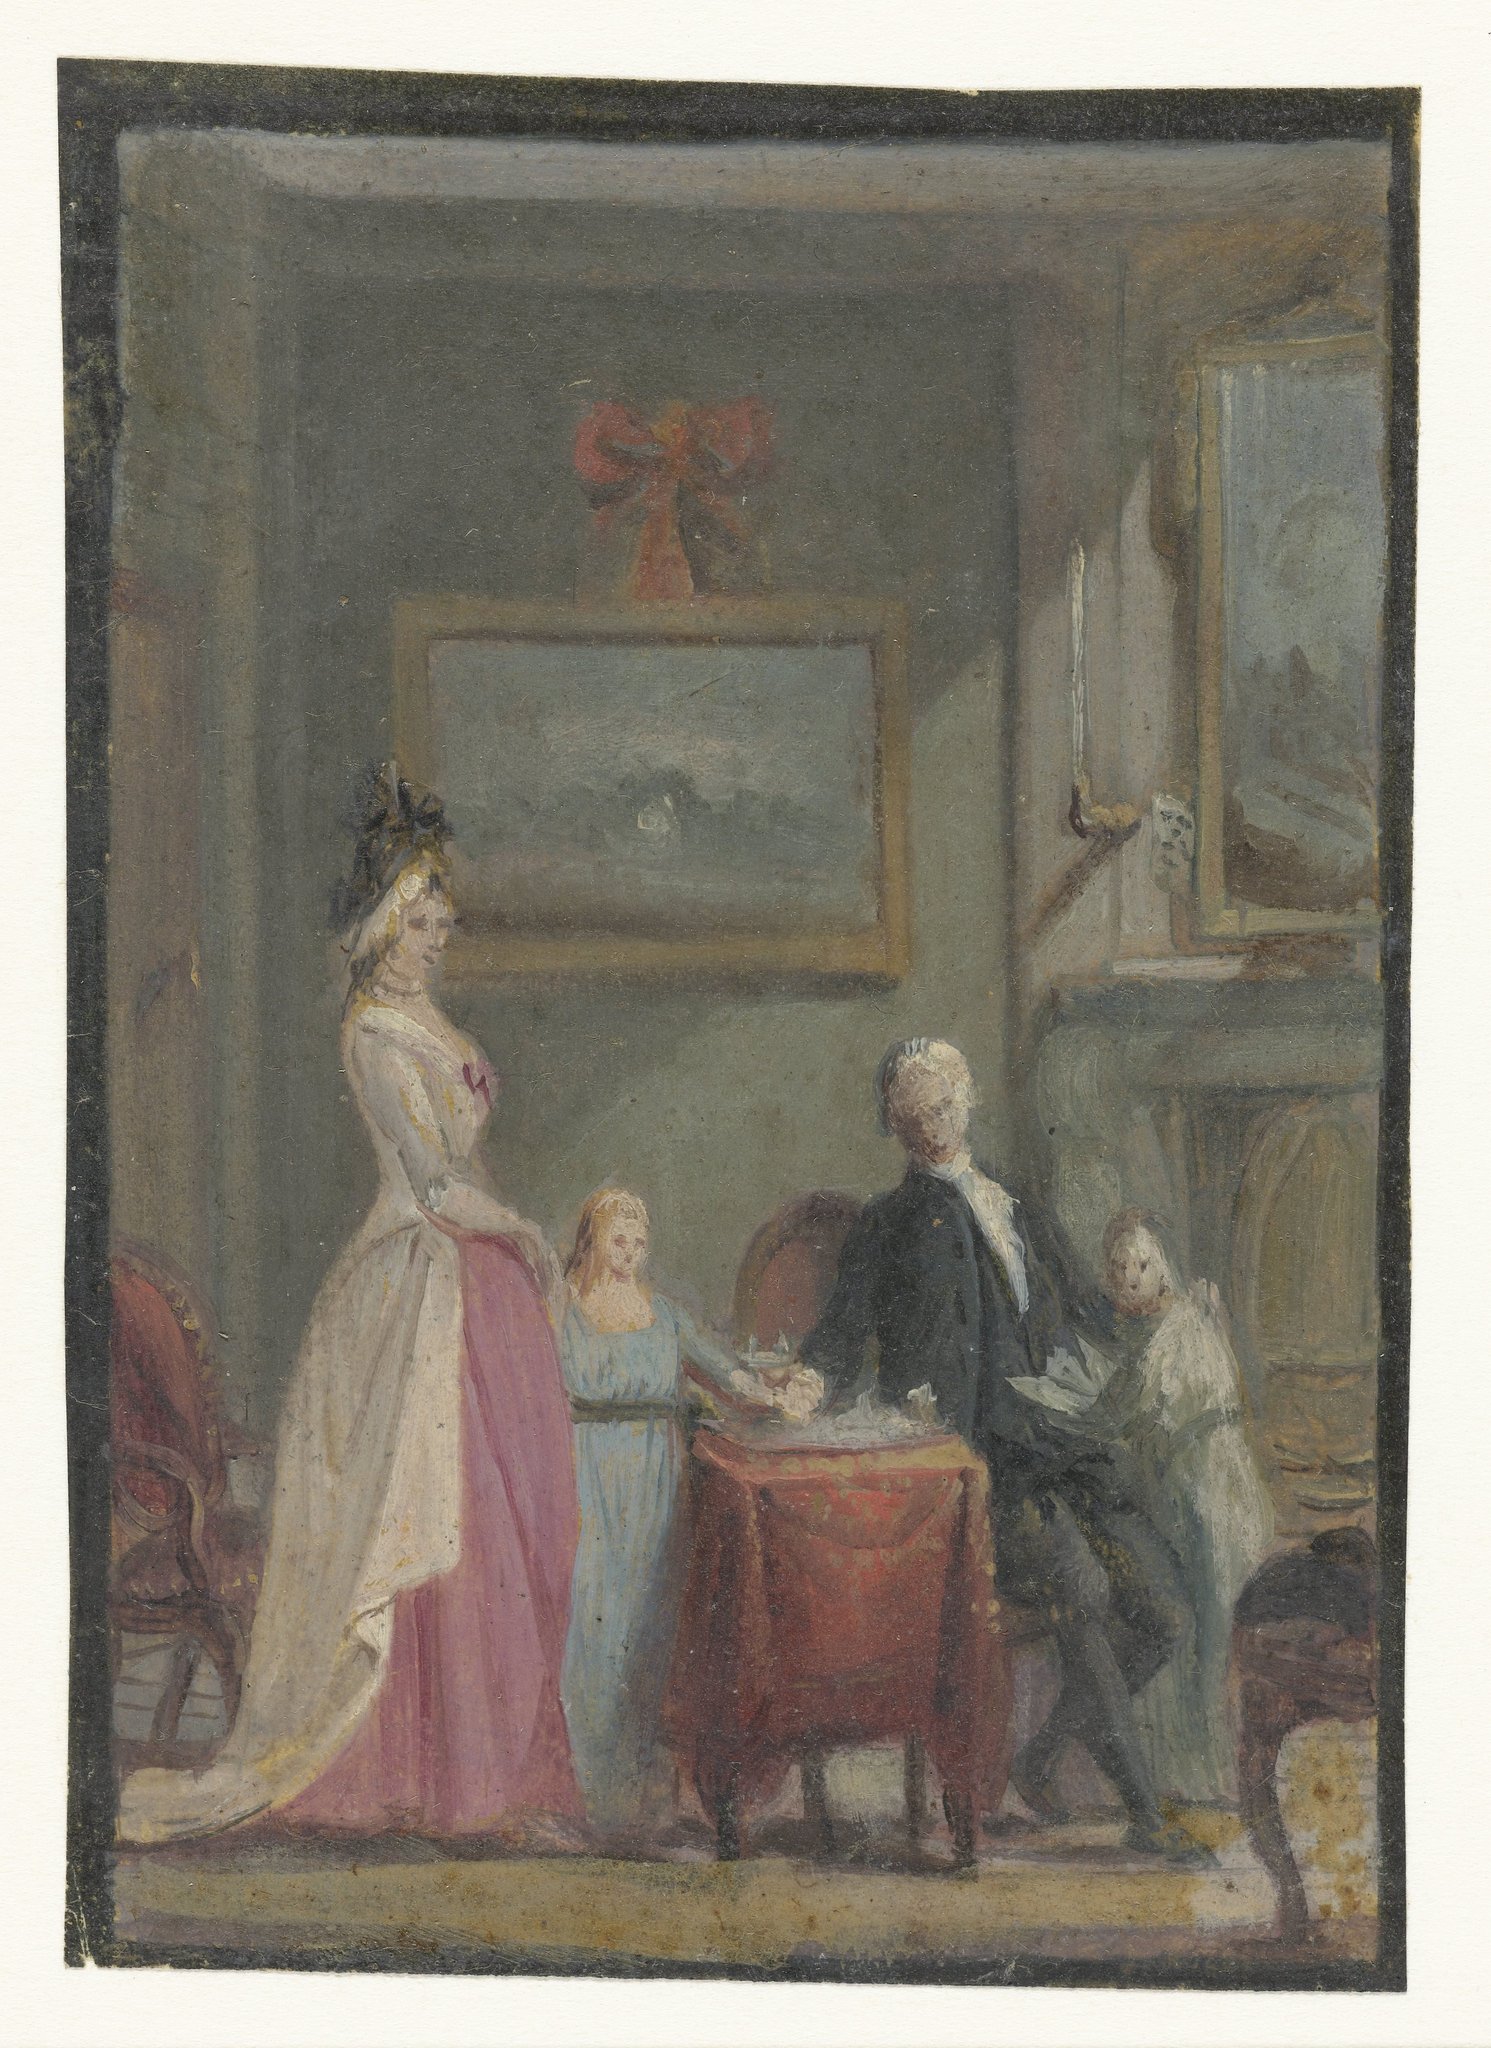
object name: drawing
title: Familiegroep in interieur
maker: Anonymous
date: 1700-1800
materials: oil, paper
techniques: brush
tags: family group, especially parents with their child(ren)